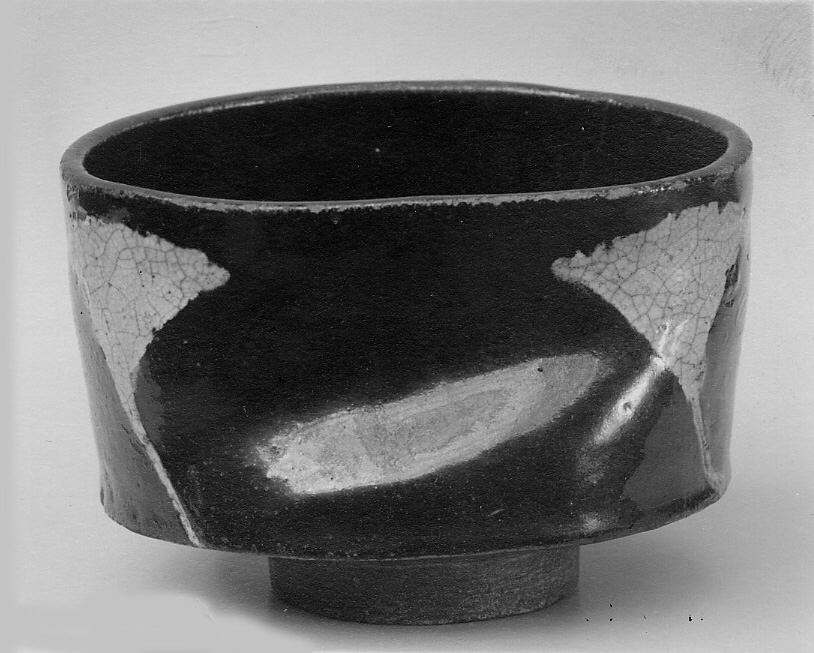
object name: teabowl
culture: japanese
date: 1780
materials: clay, glaze